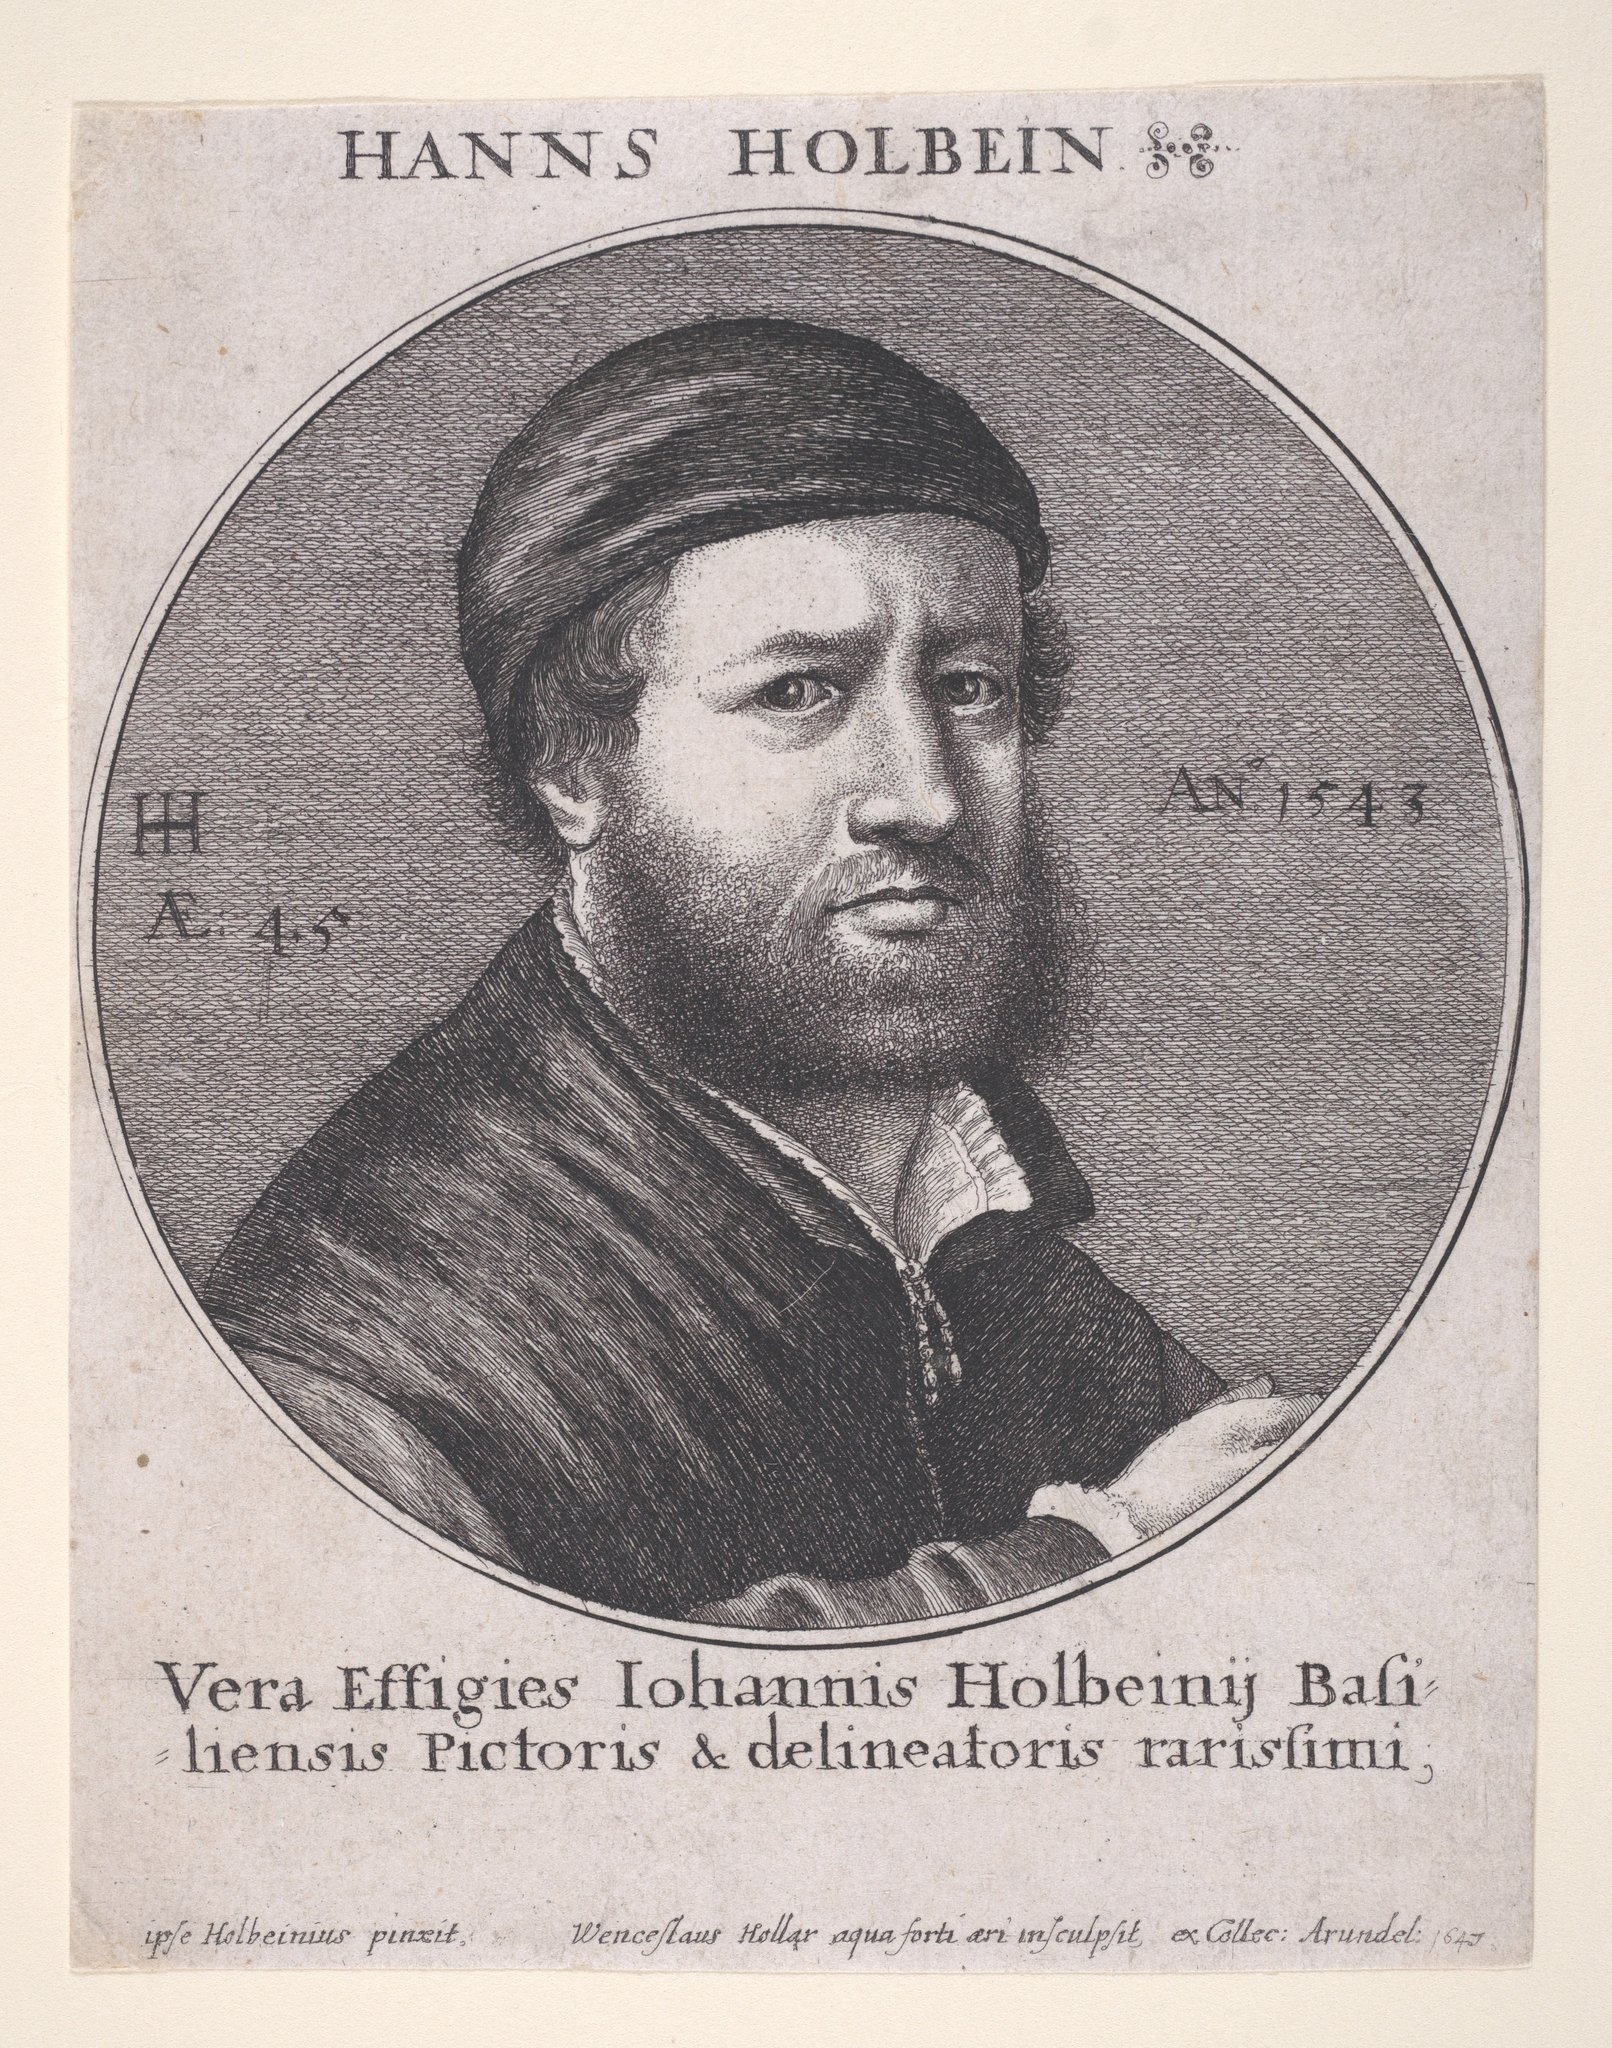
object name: print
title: Portrait of Hans Holbein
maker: wenceslaus hollar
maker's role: artist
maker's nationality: bohemian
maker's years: 1607-1677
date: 1647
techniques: engraving, etching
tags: men,portraits,artists